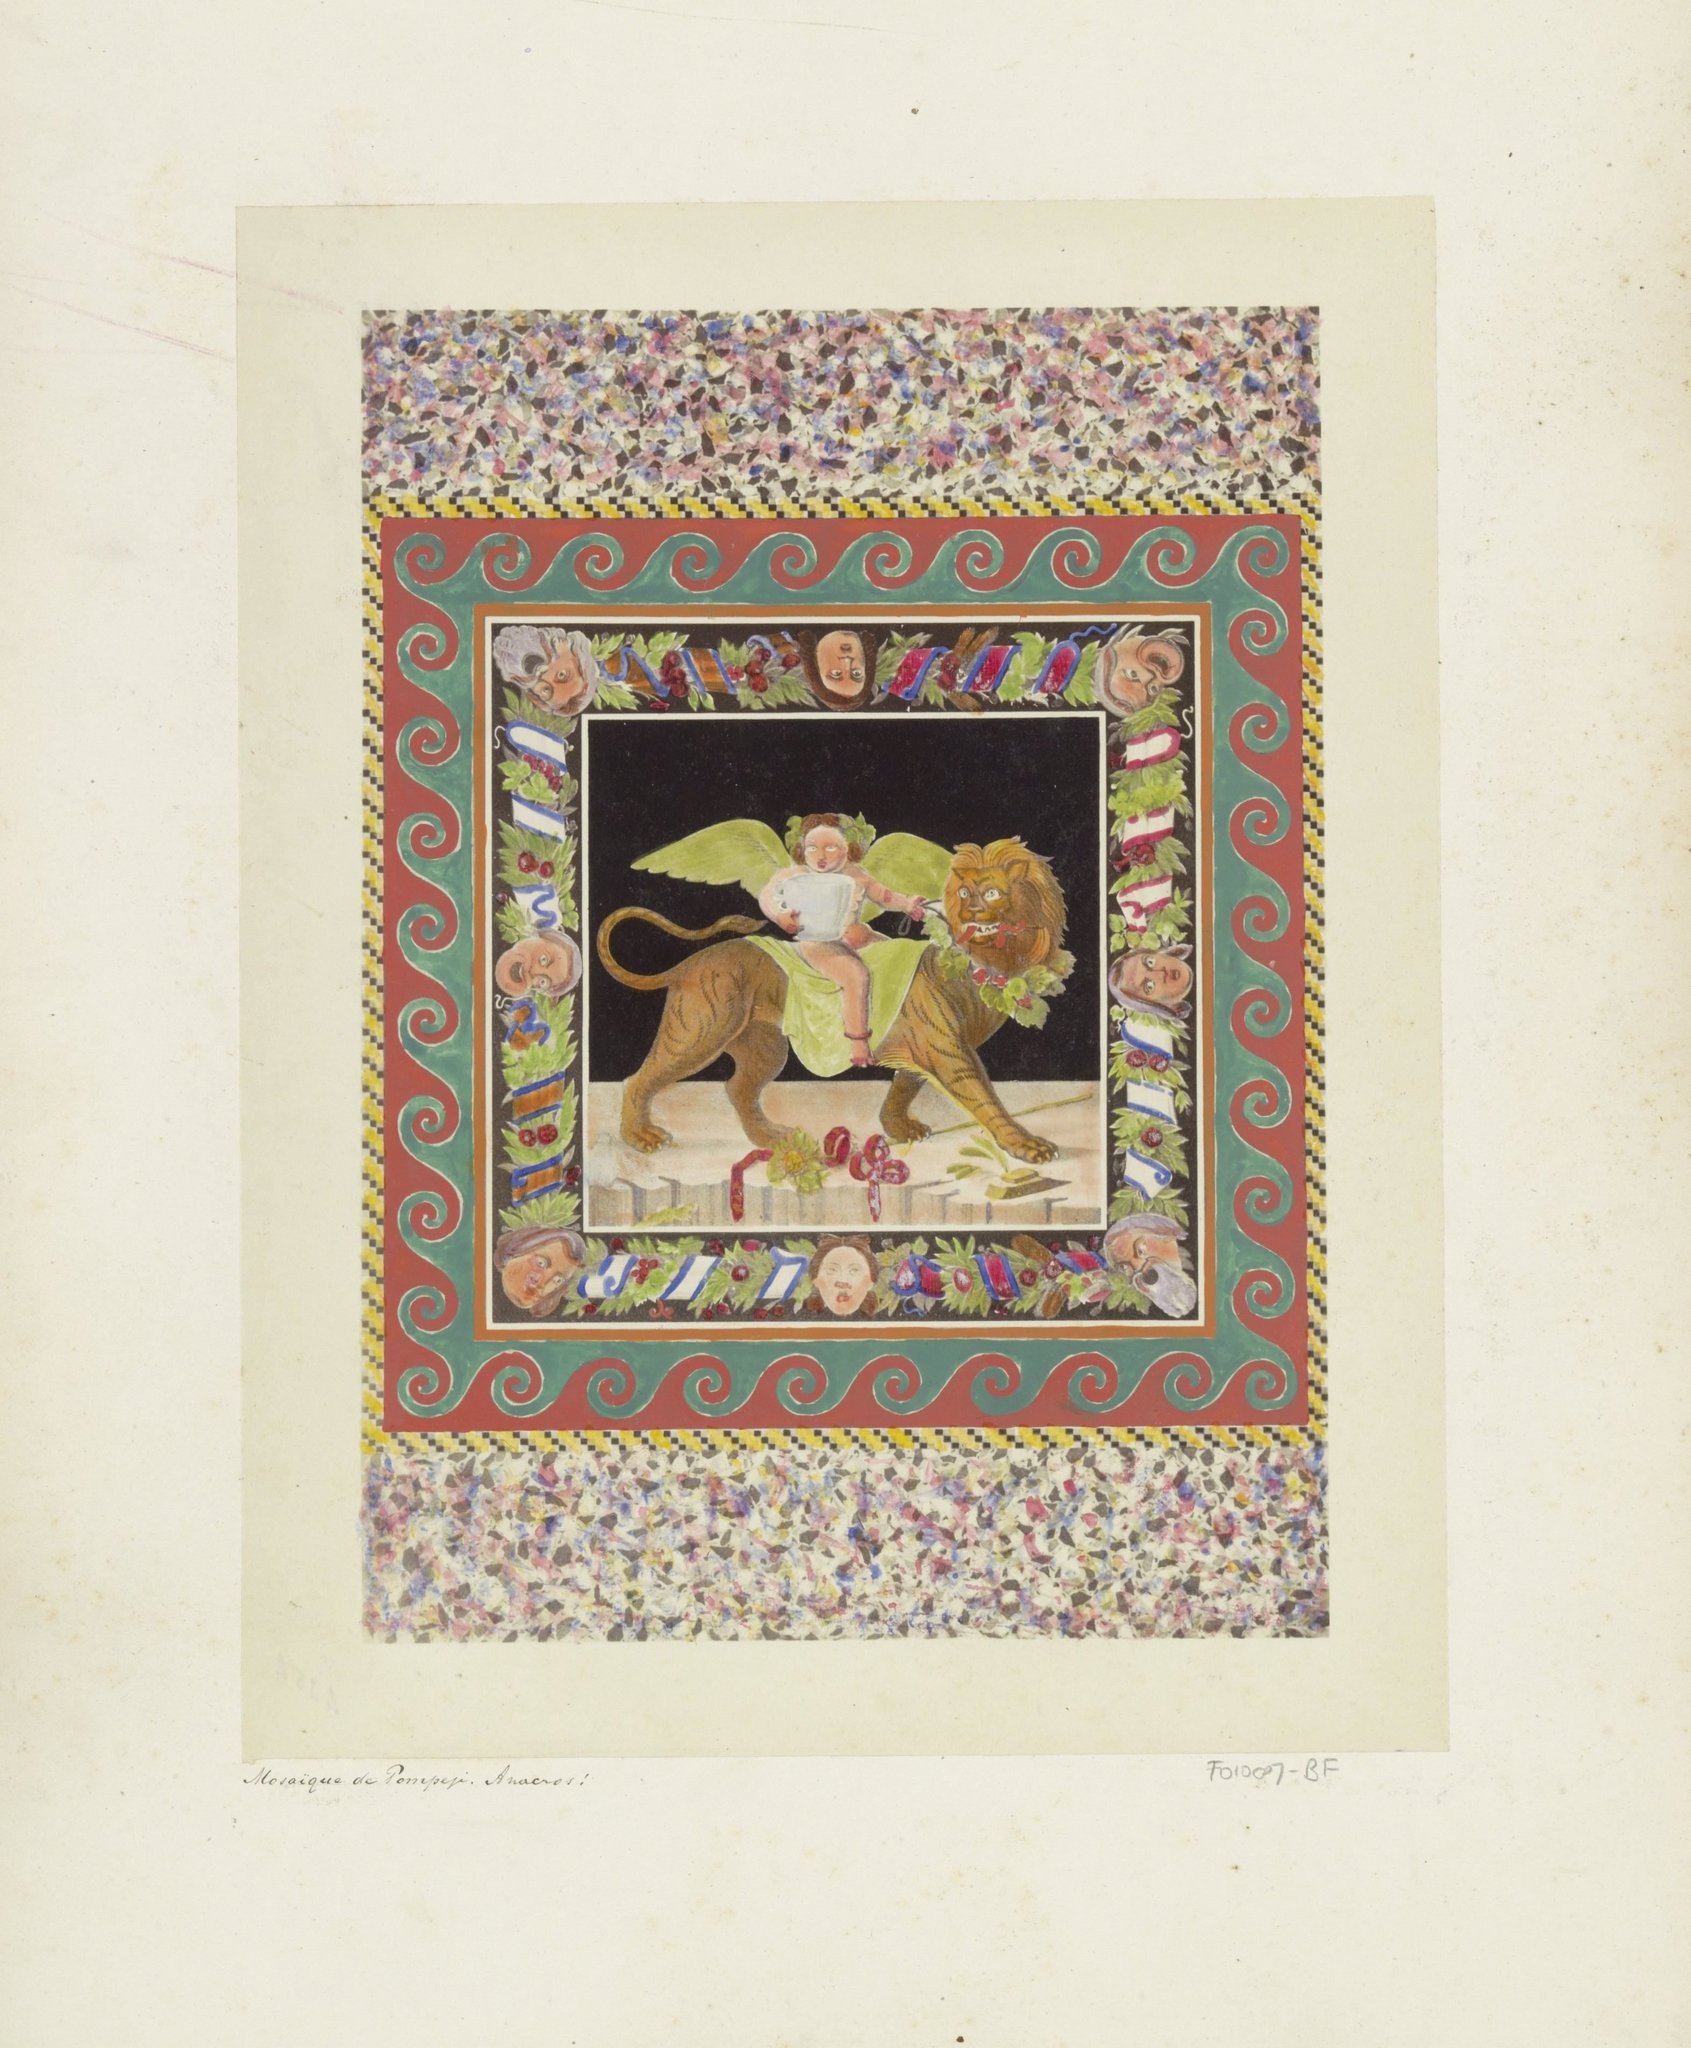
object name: reproduction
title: Mosaïque de Pompeï. Anacros!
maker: Anonymous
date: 1865-1875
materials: paper, photographic support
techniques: albumen print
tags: excavation ~ archaeology, pompeii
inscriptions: number: ‘[..]’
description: Onderdeel van Reisalbum met foto's van bezienswaardigheden in Napels en omgeving.